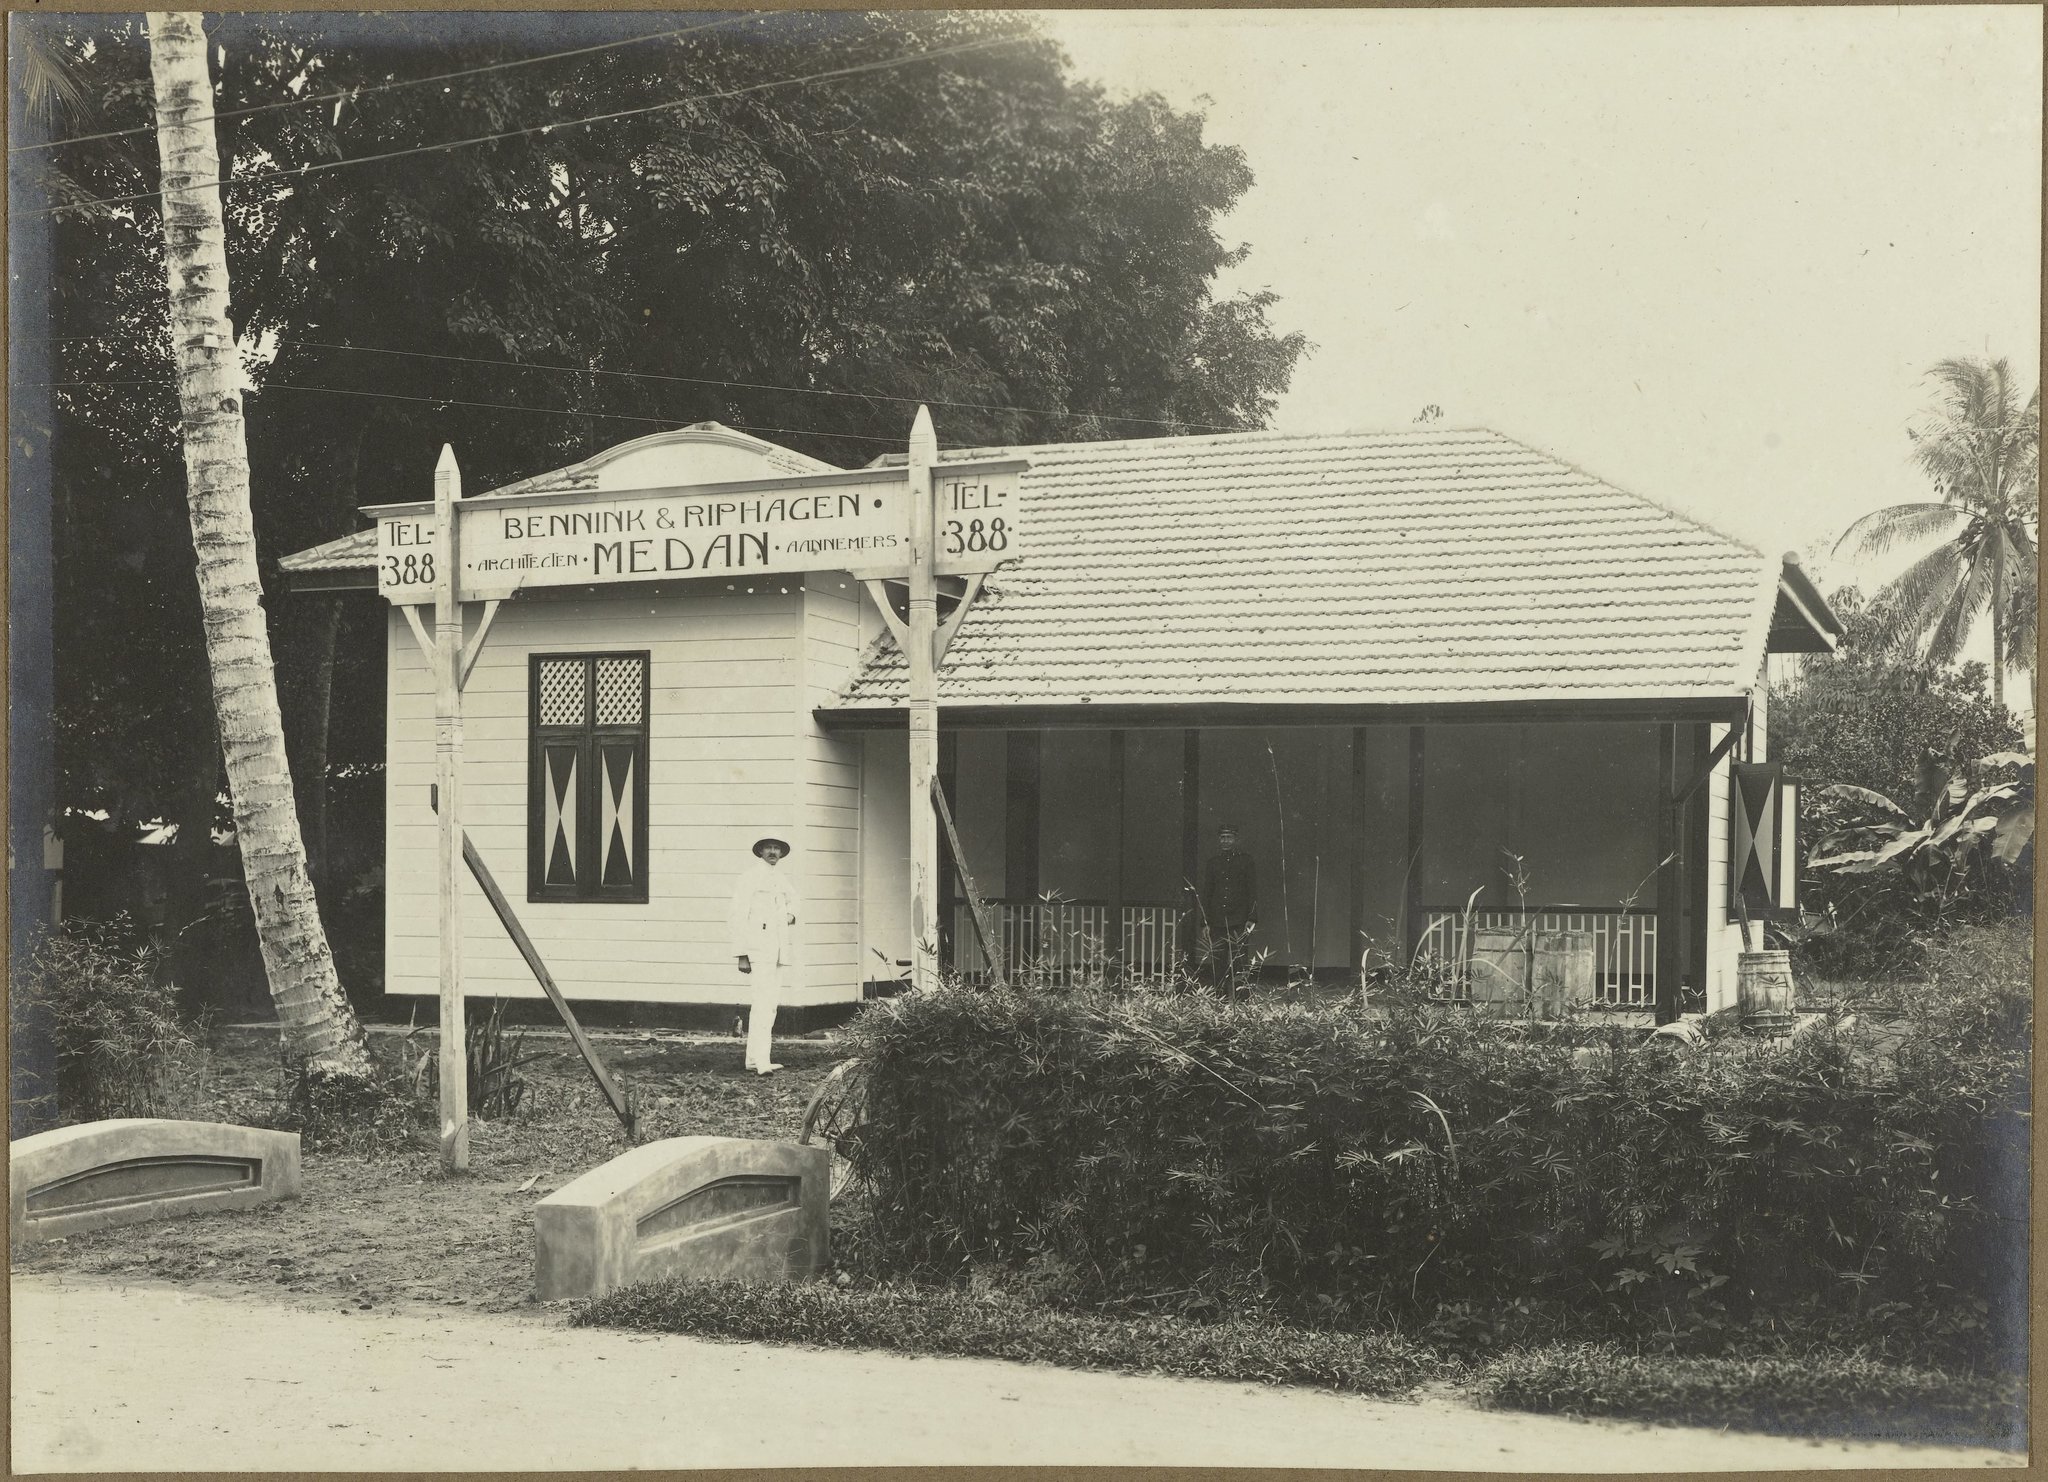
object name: photograph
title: Eerste kantoor van Bennink en Riphagen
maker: Anonymous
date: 1914-1919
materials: photographic support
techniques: gelatin silver print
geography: medan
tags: representation of real building (either existing or having existed), architecture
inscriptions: inscription: ‘Medan 1e Kantoor Hütenbachstraat ?’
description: Het eerste kantoor van het bouwbedrijf van Bennink en Riphagen aan de Huttenbachstraat te Medan. Met Bennink staande voor het pand en bij de ingang een bord met de naam en het telefoonnummer van het bedrijf. Foto in het fotoalbum van het Nederlandse architectenbureau en aannemersbedrijf Bennink en Riphagen te Medan in de jaren ca. 1914-1919.